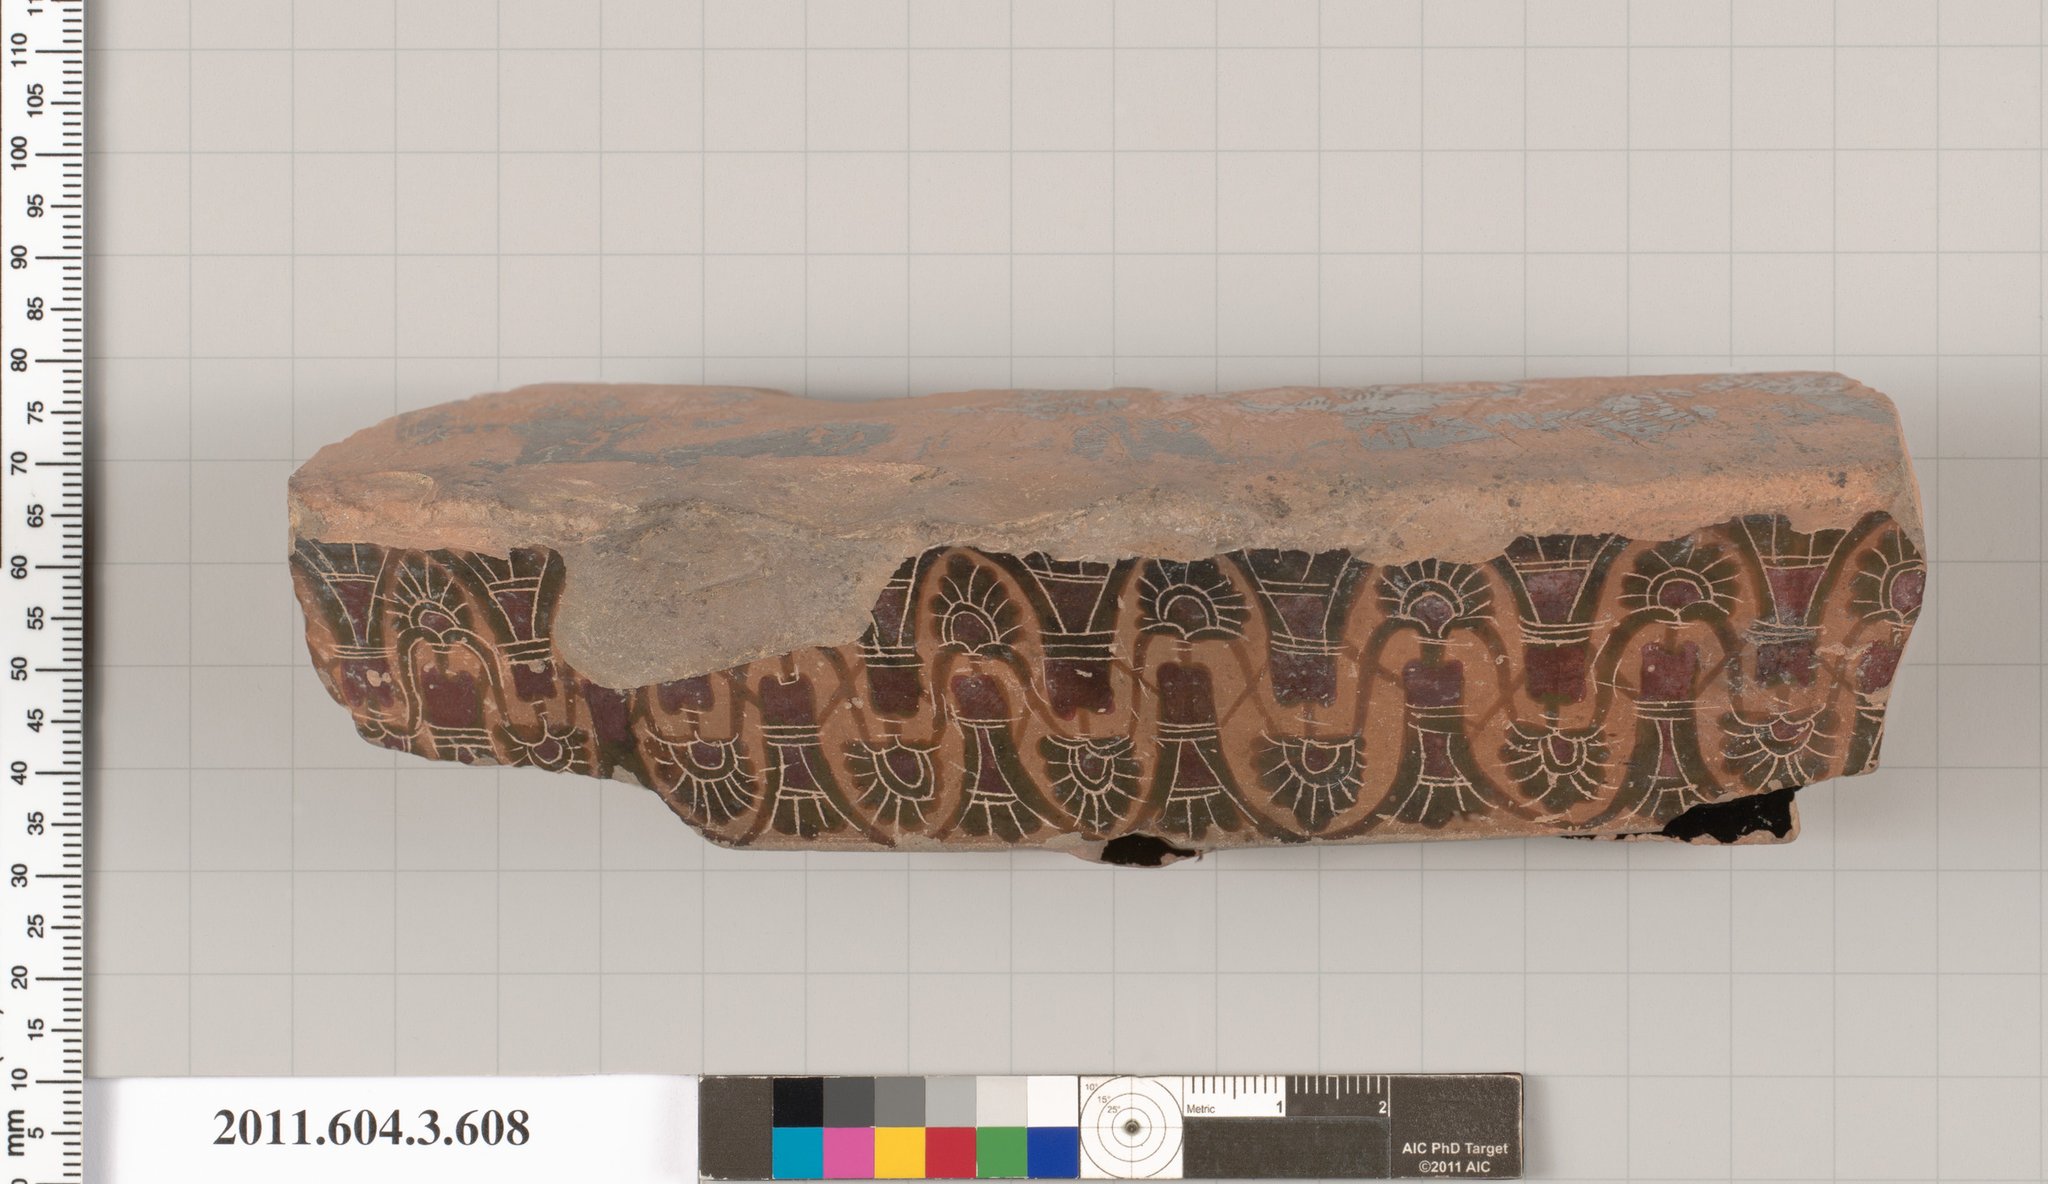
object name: column krater fragment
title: Terracotta fragment of a column-krater (bowl for mixing wine and water)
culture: greek, attic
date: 550-526 BCE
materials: terracotta